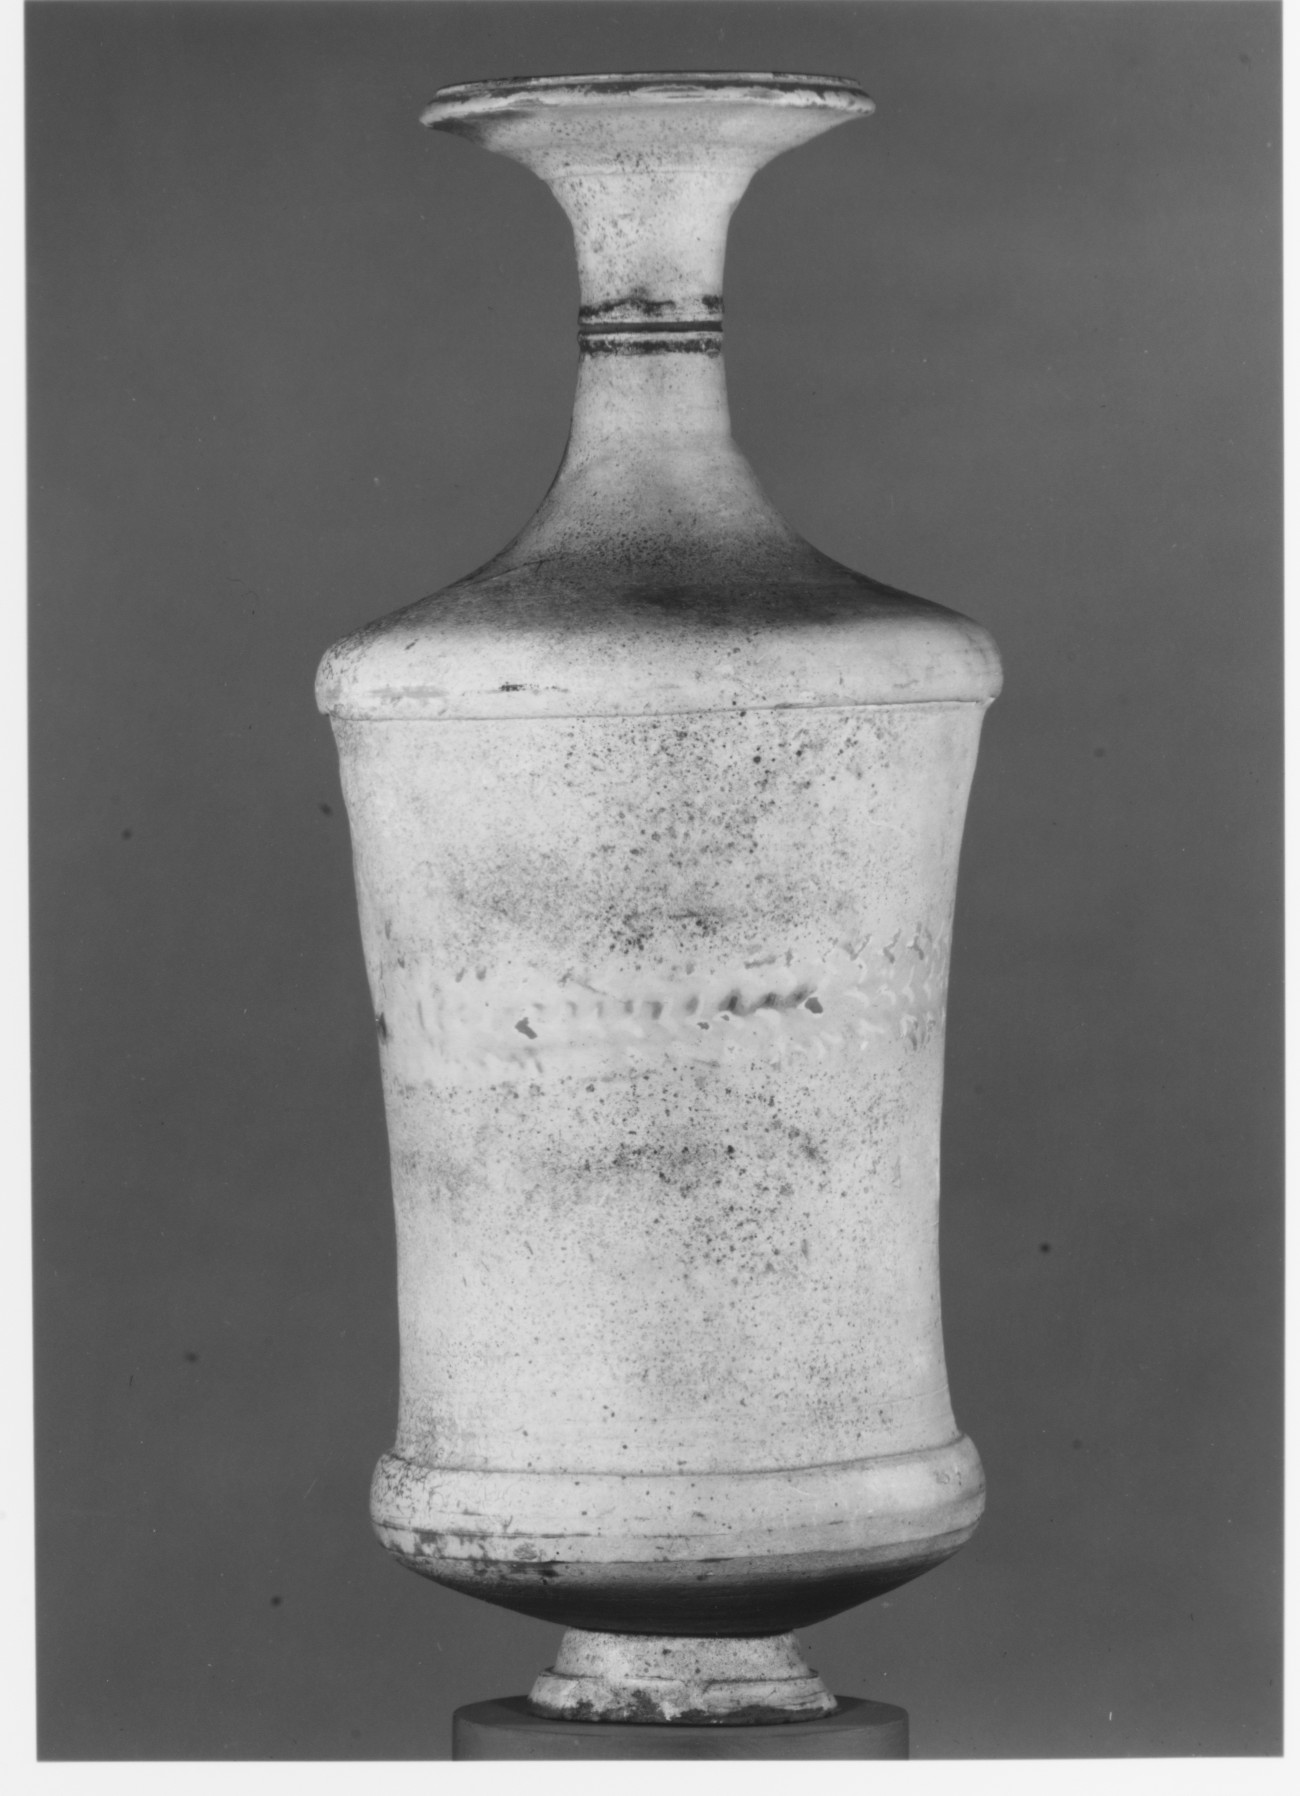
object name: loutrophoros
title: Terracotta loutrophoros (ceremonial vase for water)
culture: greek, south italian, apulian, canosan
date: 334-268 BCE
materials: terracotta